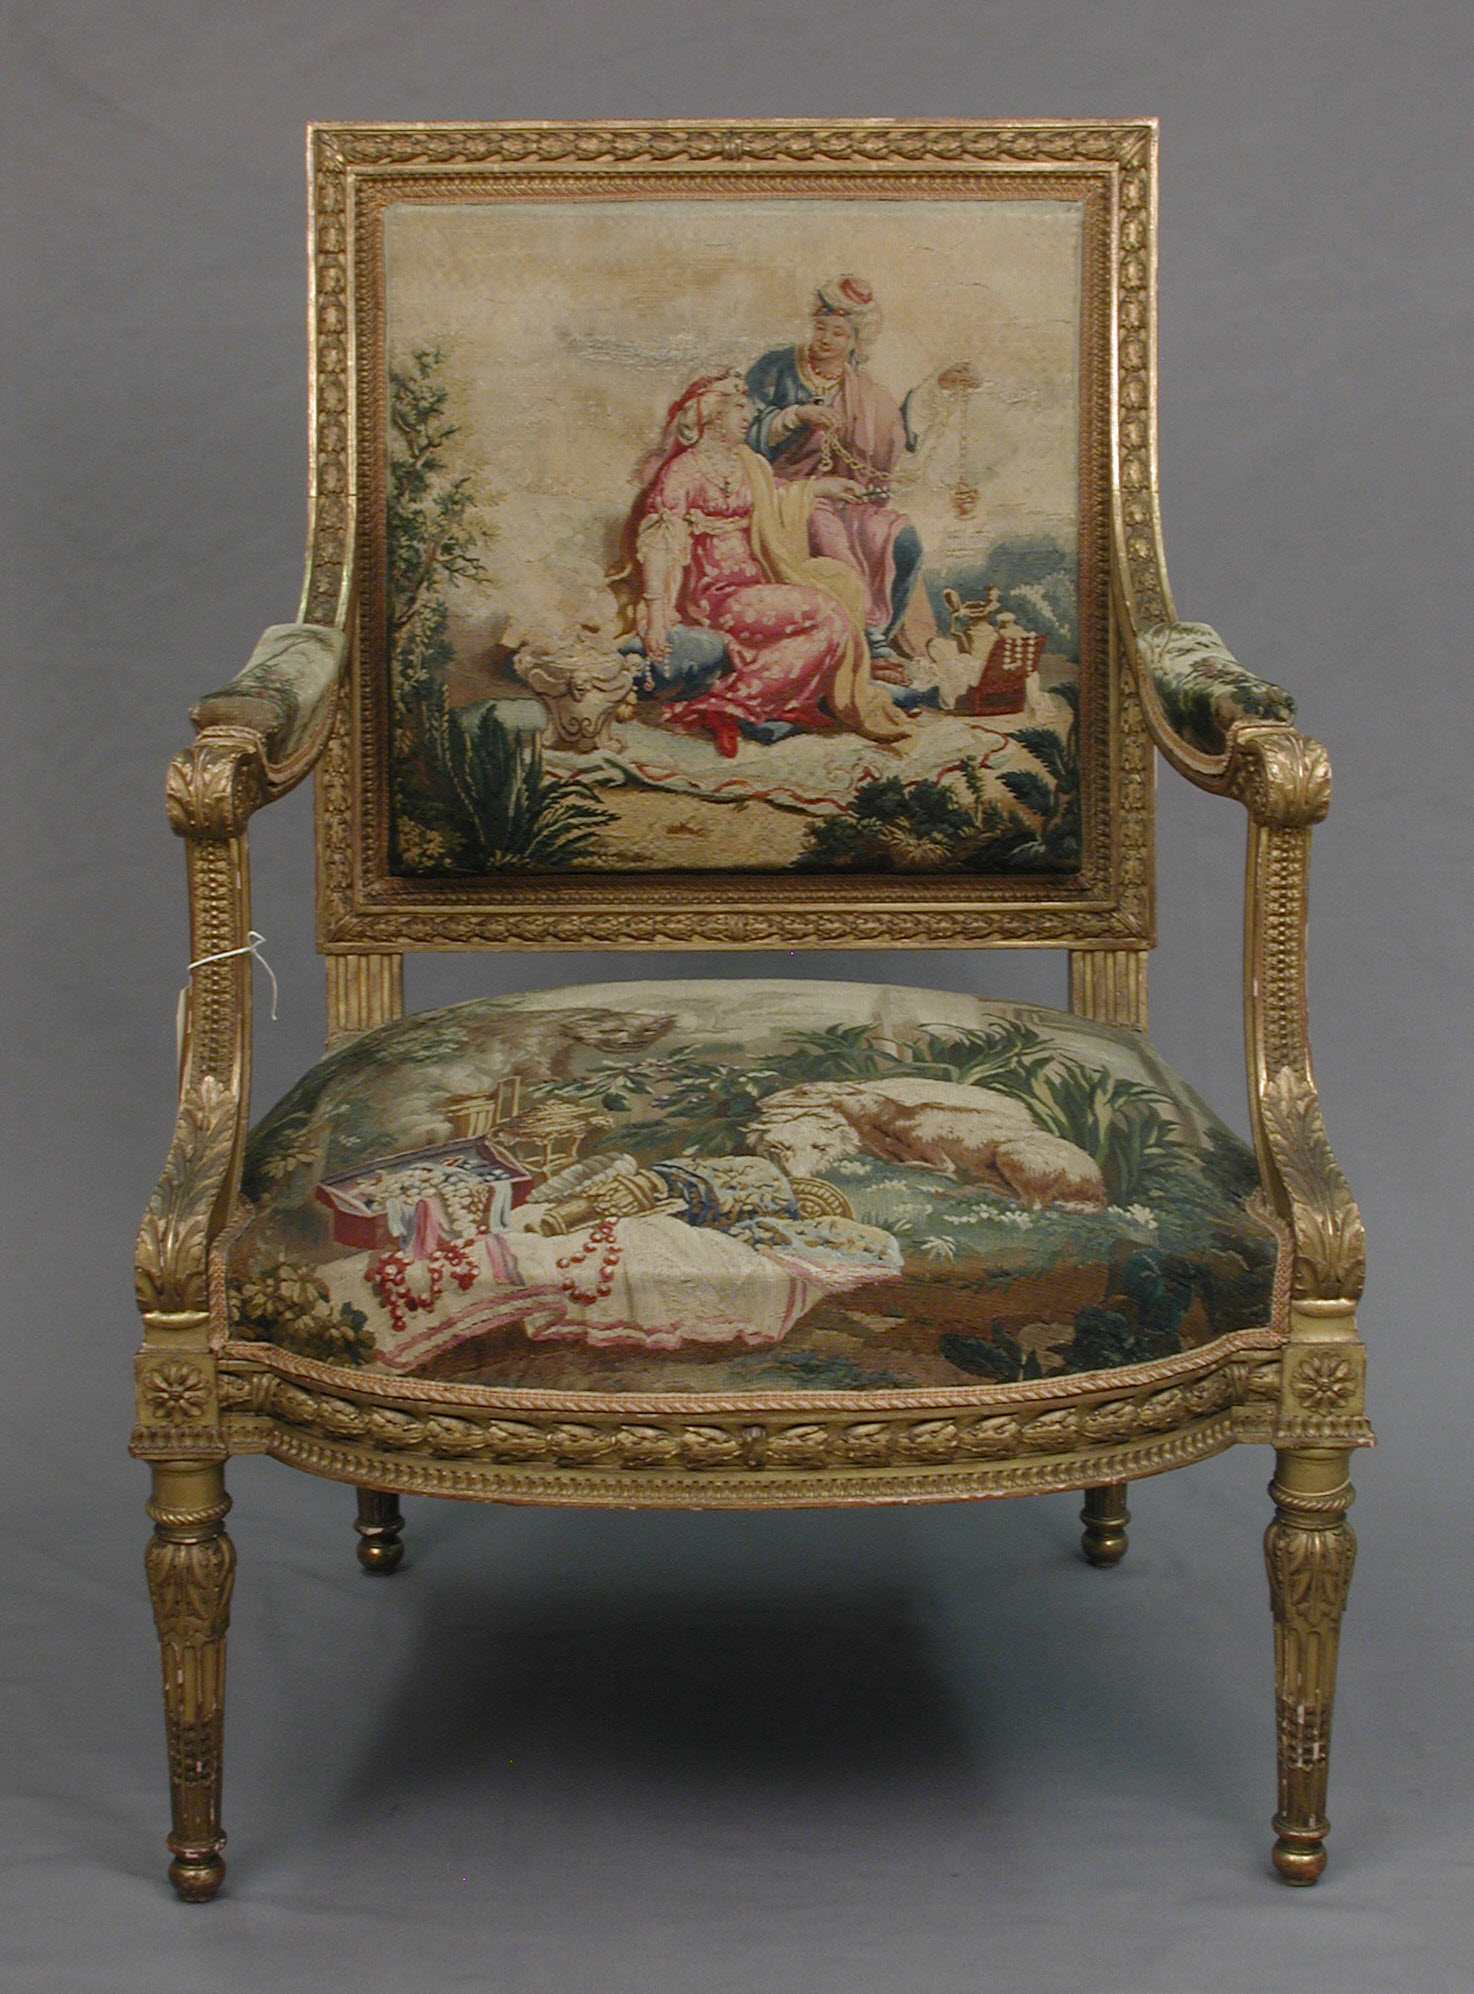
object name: armchair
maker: beauvais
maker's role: manufactory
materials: silk, wood, wool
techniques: carving, gilding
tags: animals,men,women,sheep